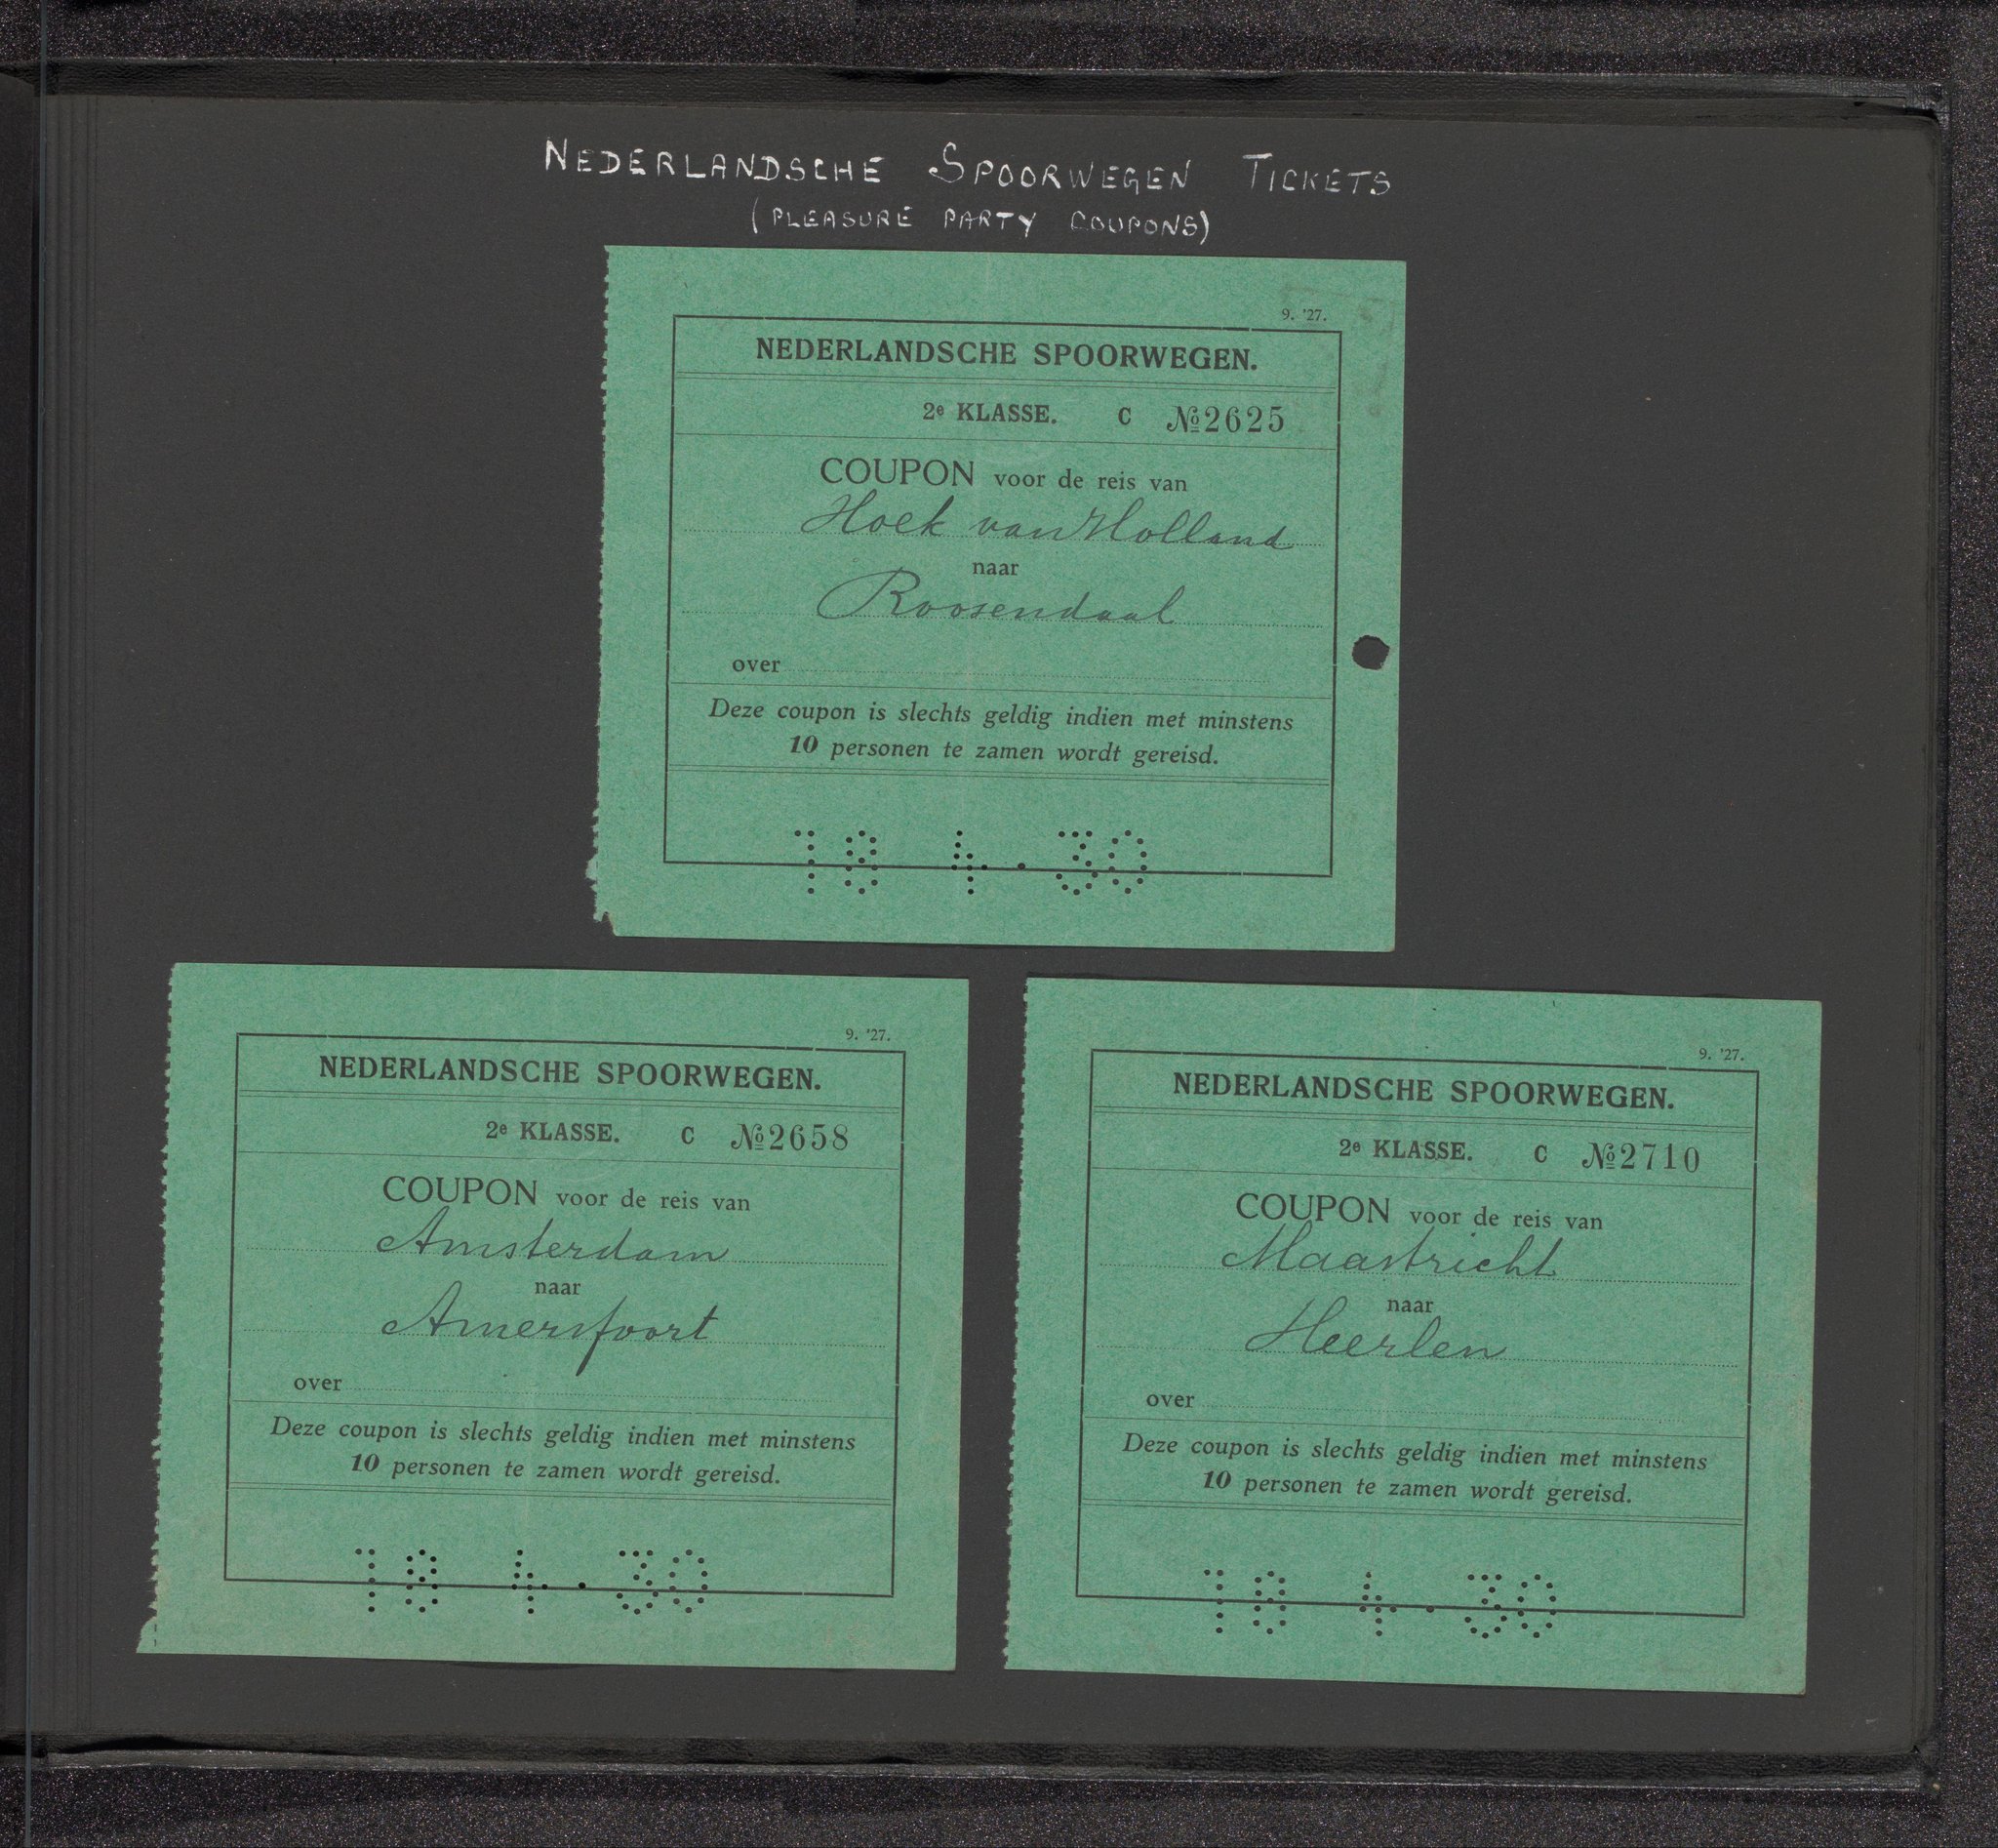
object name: album leaf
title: Treinkaartjes voor groepsvervoer van de Nederlandse Spoorwegen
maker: Anonymous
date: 1930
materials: cardboard, ink, paper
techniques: printing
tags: railway, train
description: Albumblad met drie treinkaartjes 2e klas voor de trajecten Hoek van Holland-Roosendaal, Amsterdam-Amersfoort en Maastricht-Heerlen. Onderdeel van Fotografische reisverslag van het bezoek van de Stephenson Locomotive Society aan Nederland.